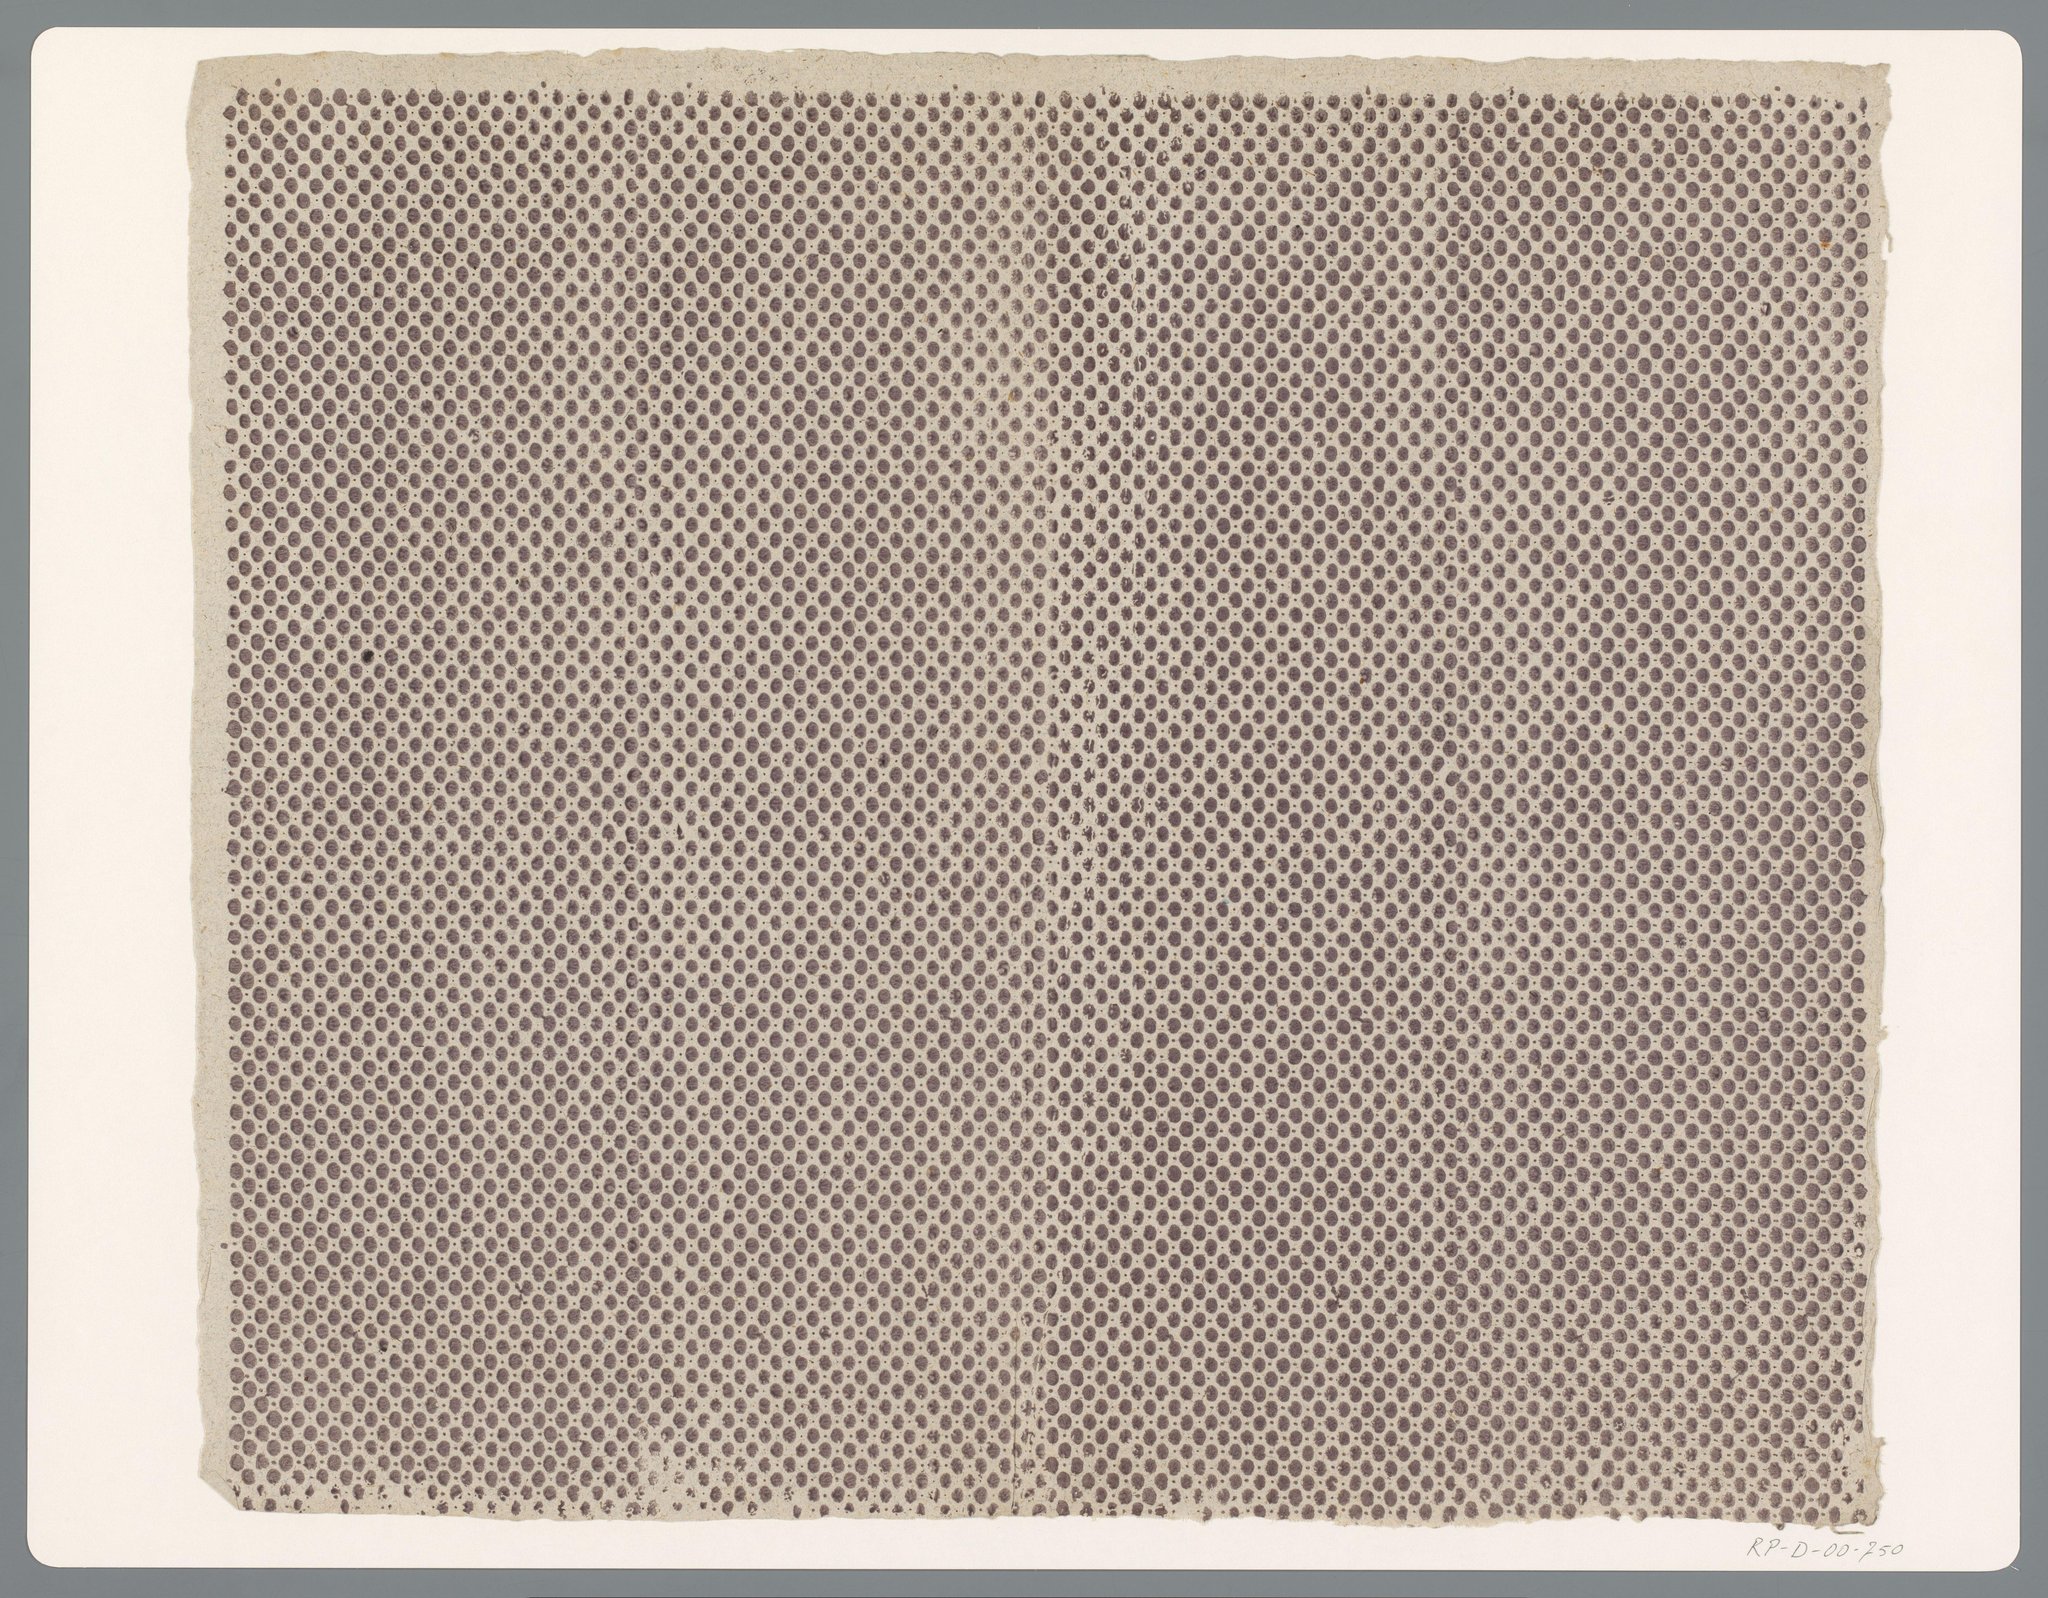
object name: printed paper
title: Blad met strooipatroon van ovaal motief en punten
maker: Anonymous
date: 1750-1950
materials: paper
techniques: printing block